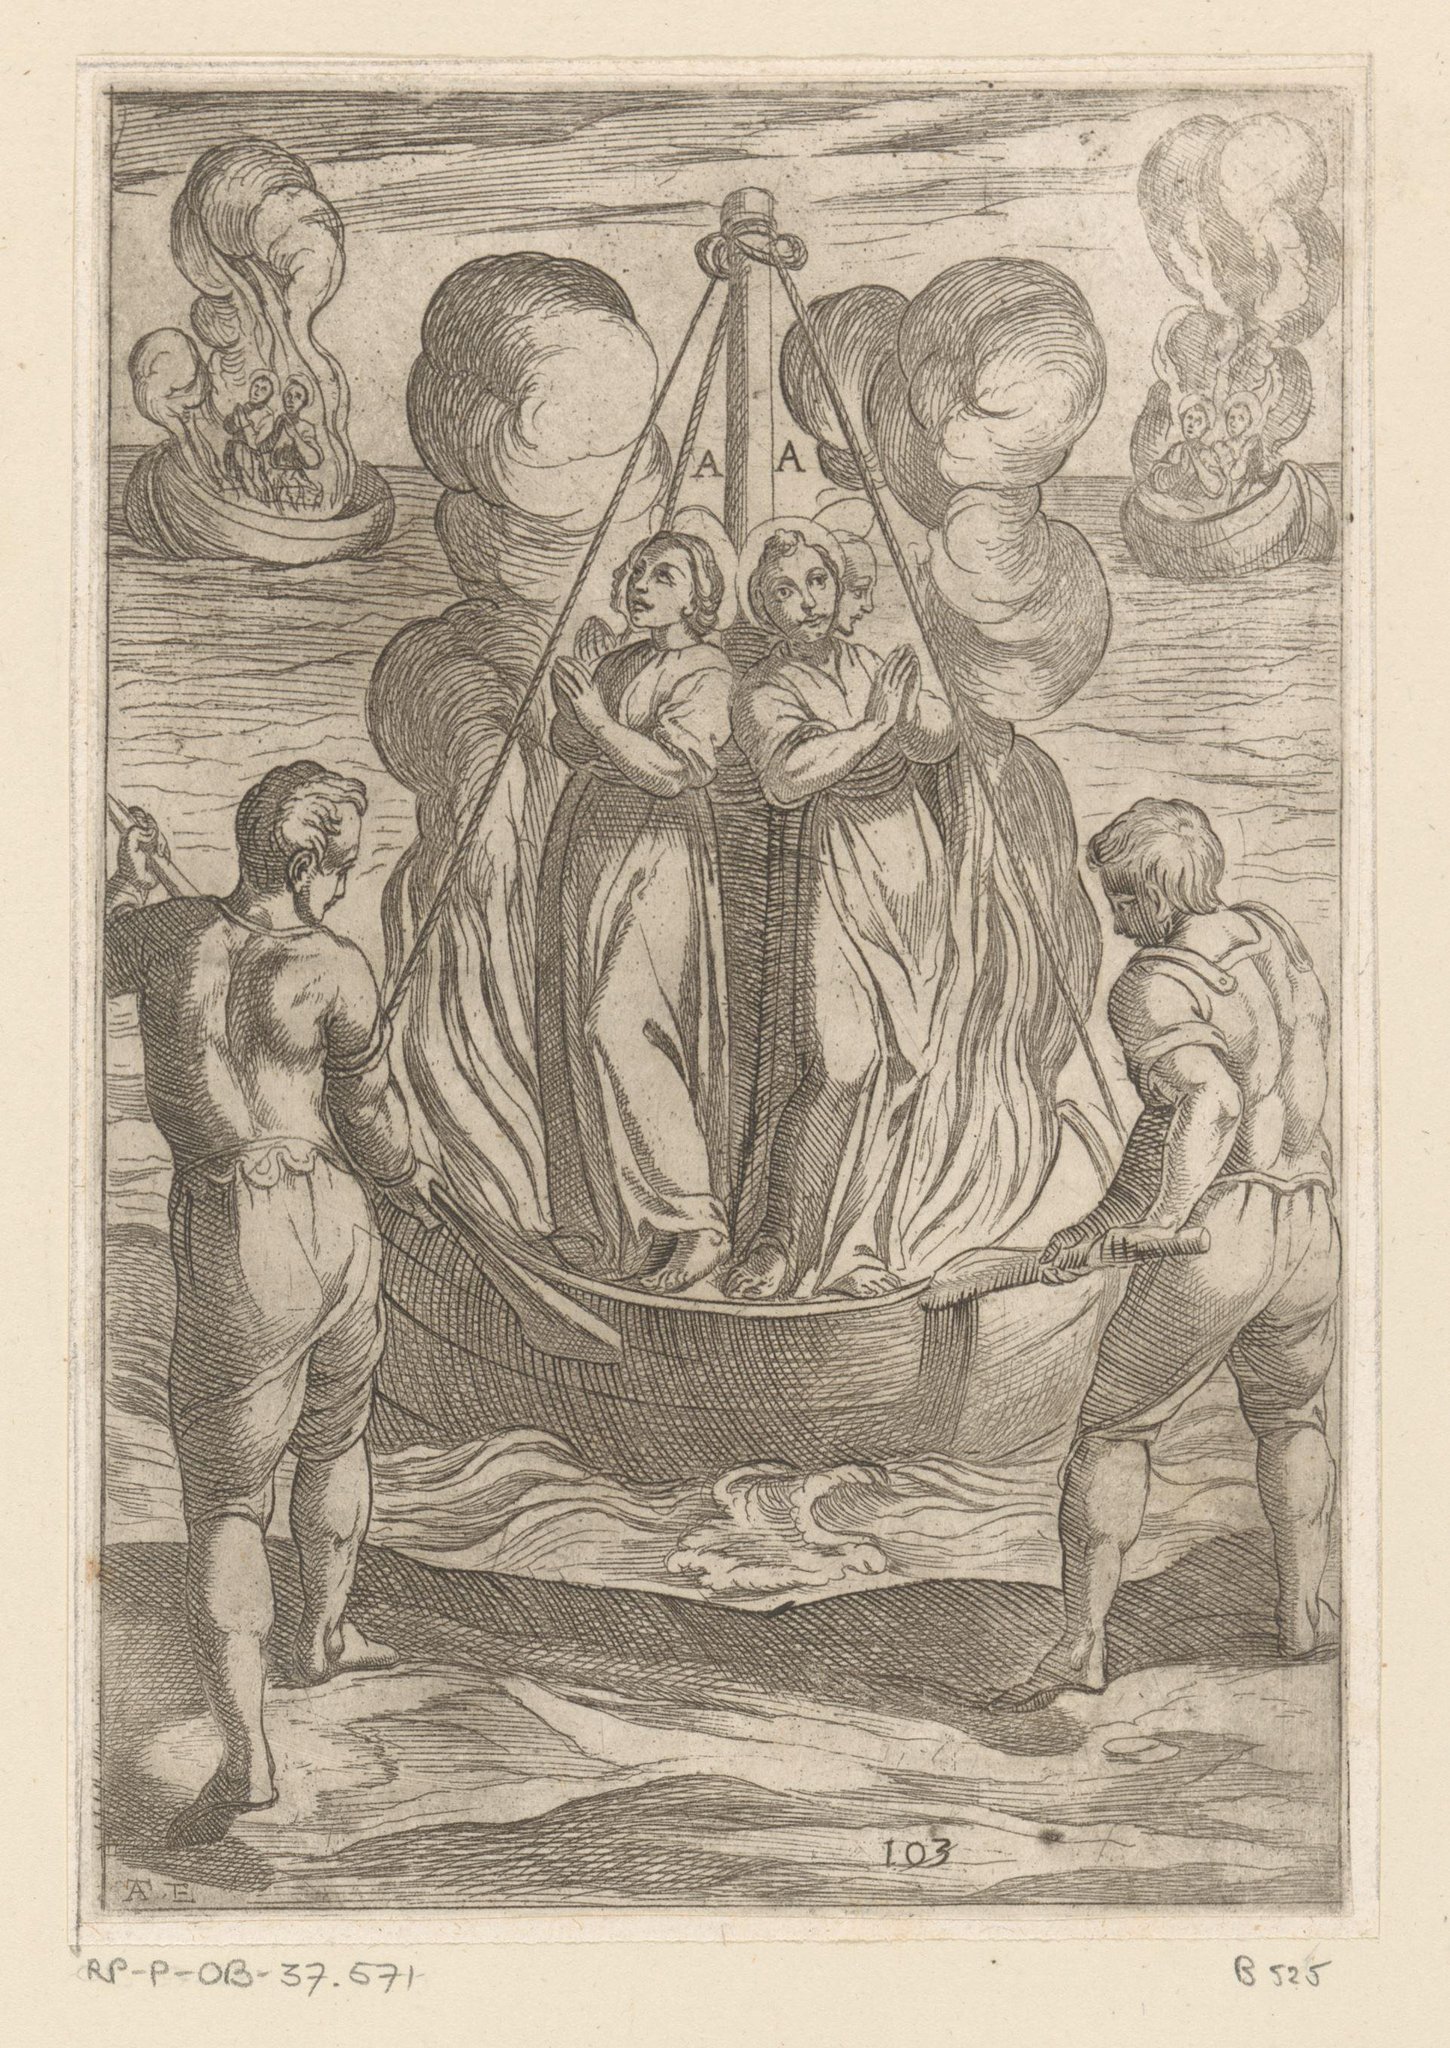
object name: print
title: Varia tormentorum et supplicioru crudelium (...)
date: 1565-1630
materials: paper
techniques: etching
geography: italy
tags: violent death ~ maltreatment, torture, torture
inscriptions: collector's mark: Lugt 240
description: Deze prent maakt deel uit van een reeks van 47 prenten (+ titelprent) met voorstellingen van martelmethoden. Deze prenten zijn in een andere editie gebruikt als illustraties voor Antonio Gallonio's 'Trattato degli Instrumenti di Martirio e delle Varie Maniere di Martoriare Usate dai Gentili contro Christiani' (Rome, Ascanio en Girolamo Dongangeli, 1591).